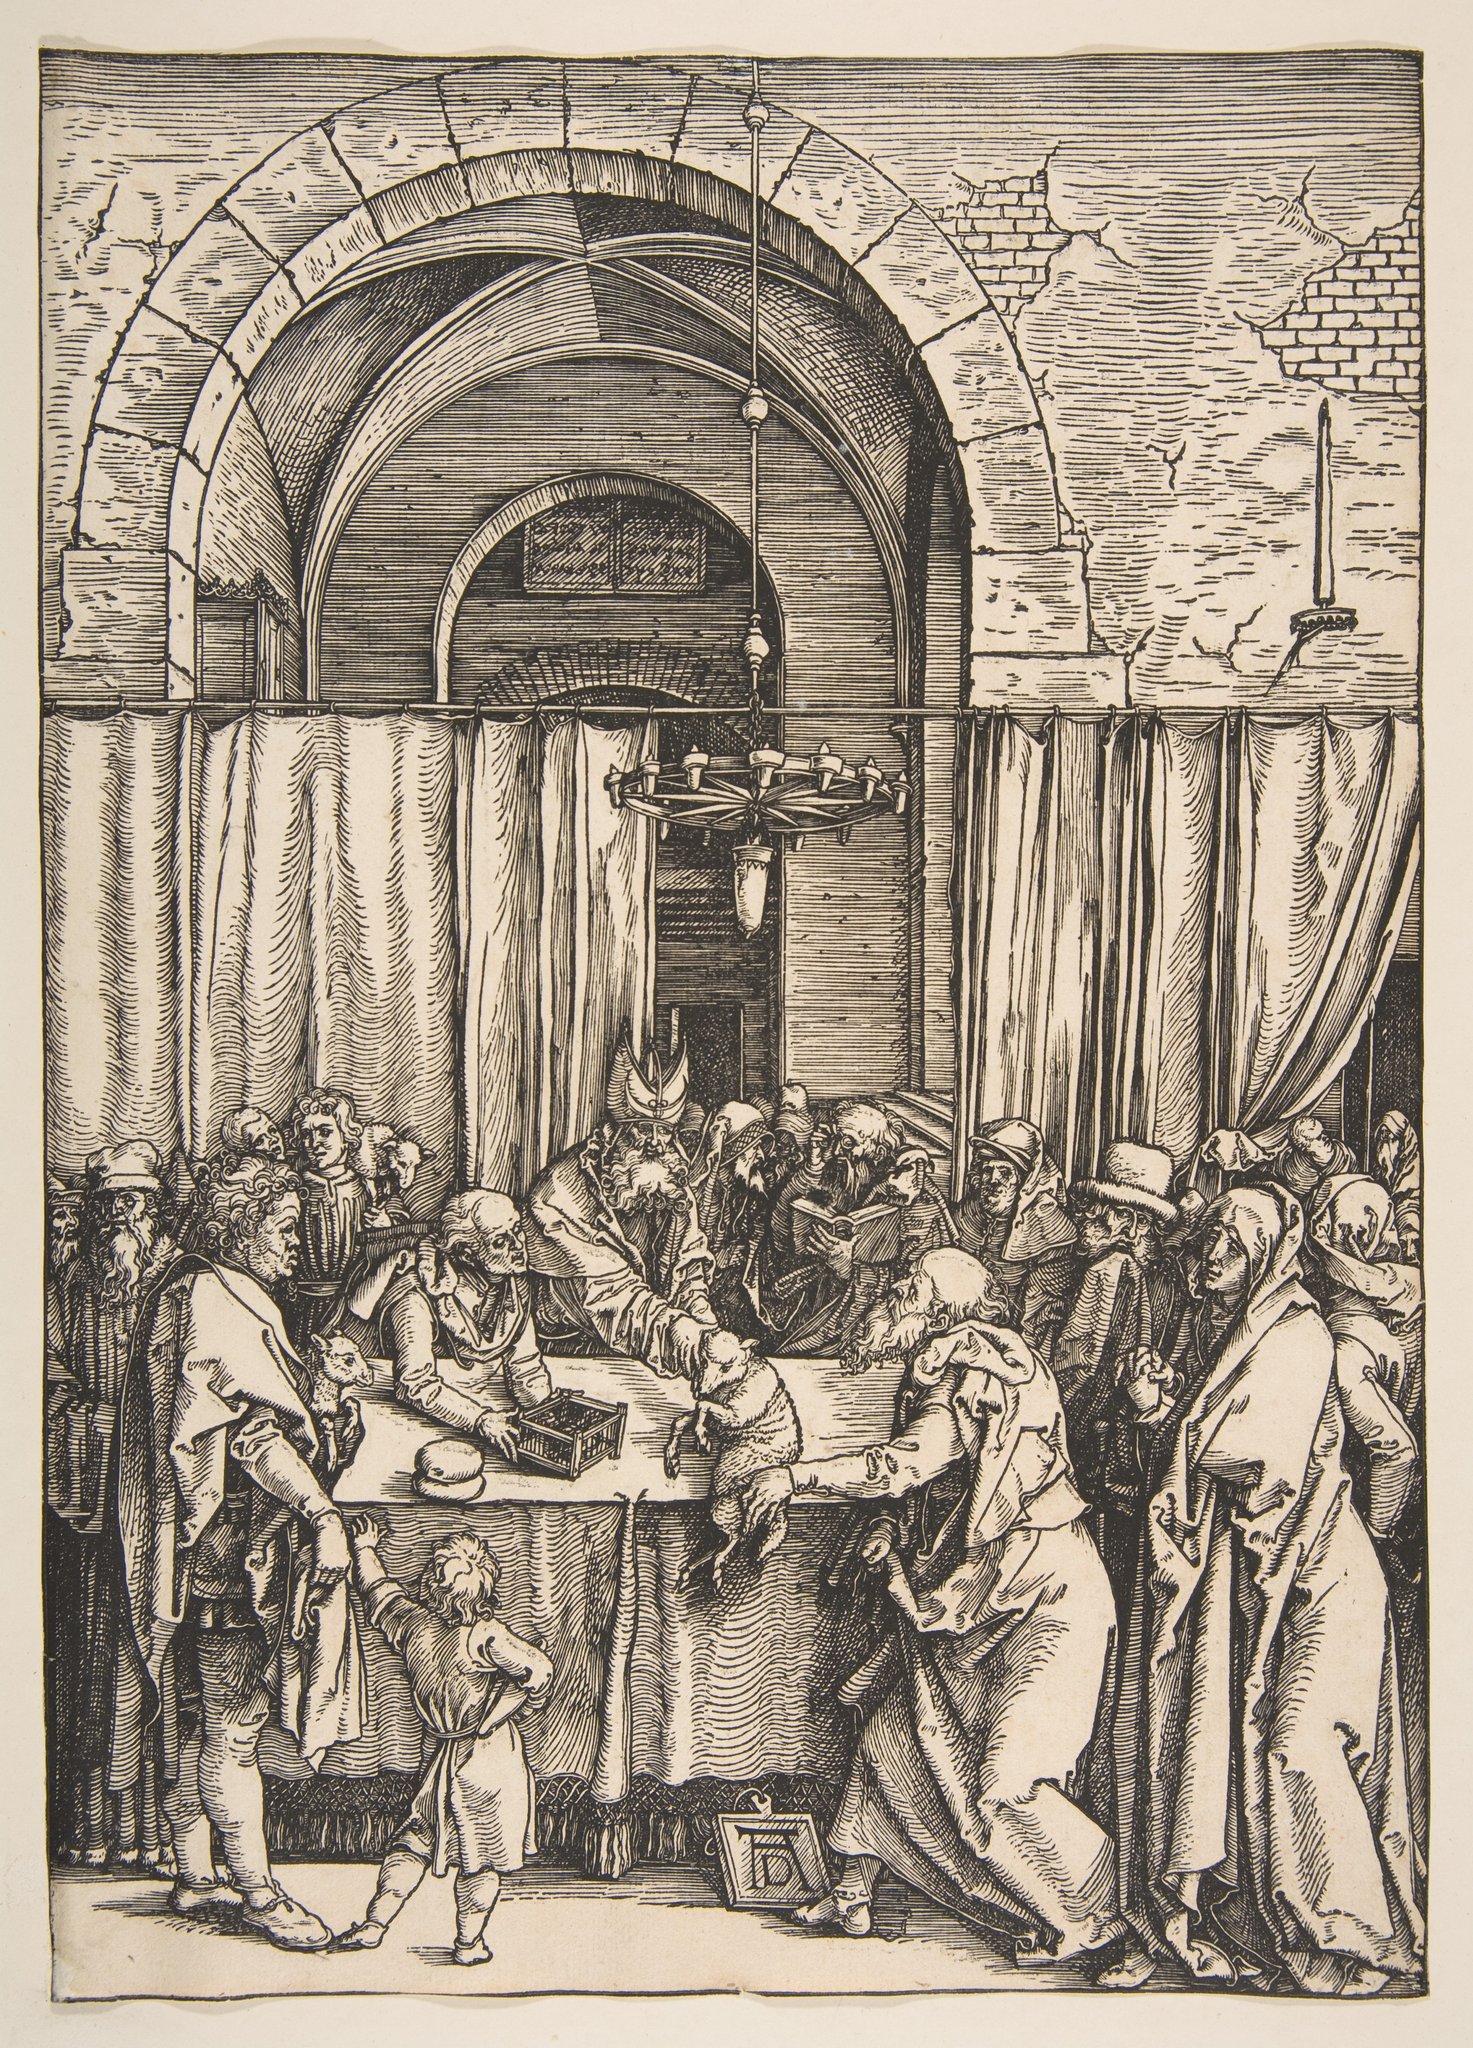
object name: print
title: The Rejection of Joachim's Offering, from The Life of the Virgin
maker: albrecht dürer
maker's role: artist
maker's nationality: german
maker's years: 1471-1528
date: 1504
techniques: woodcut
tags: men,sheep,saints